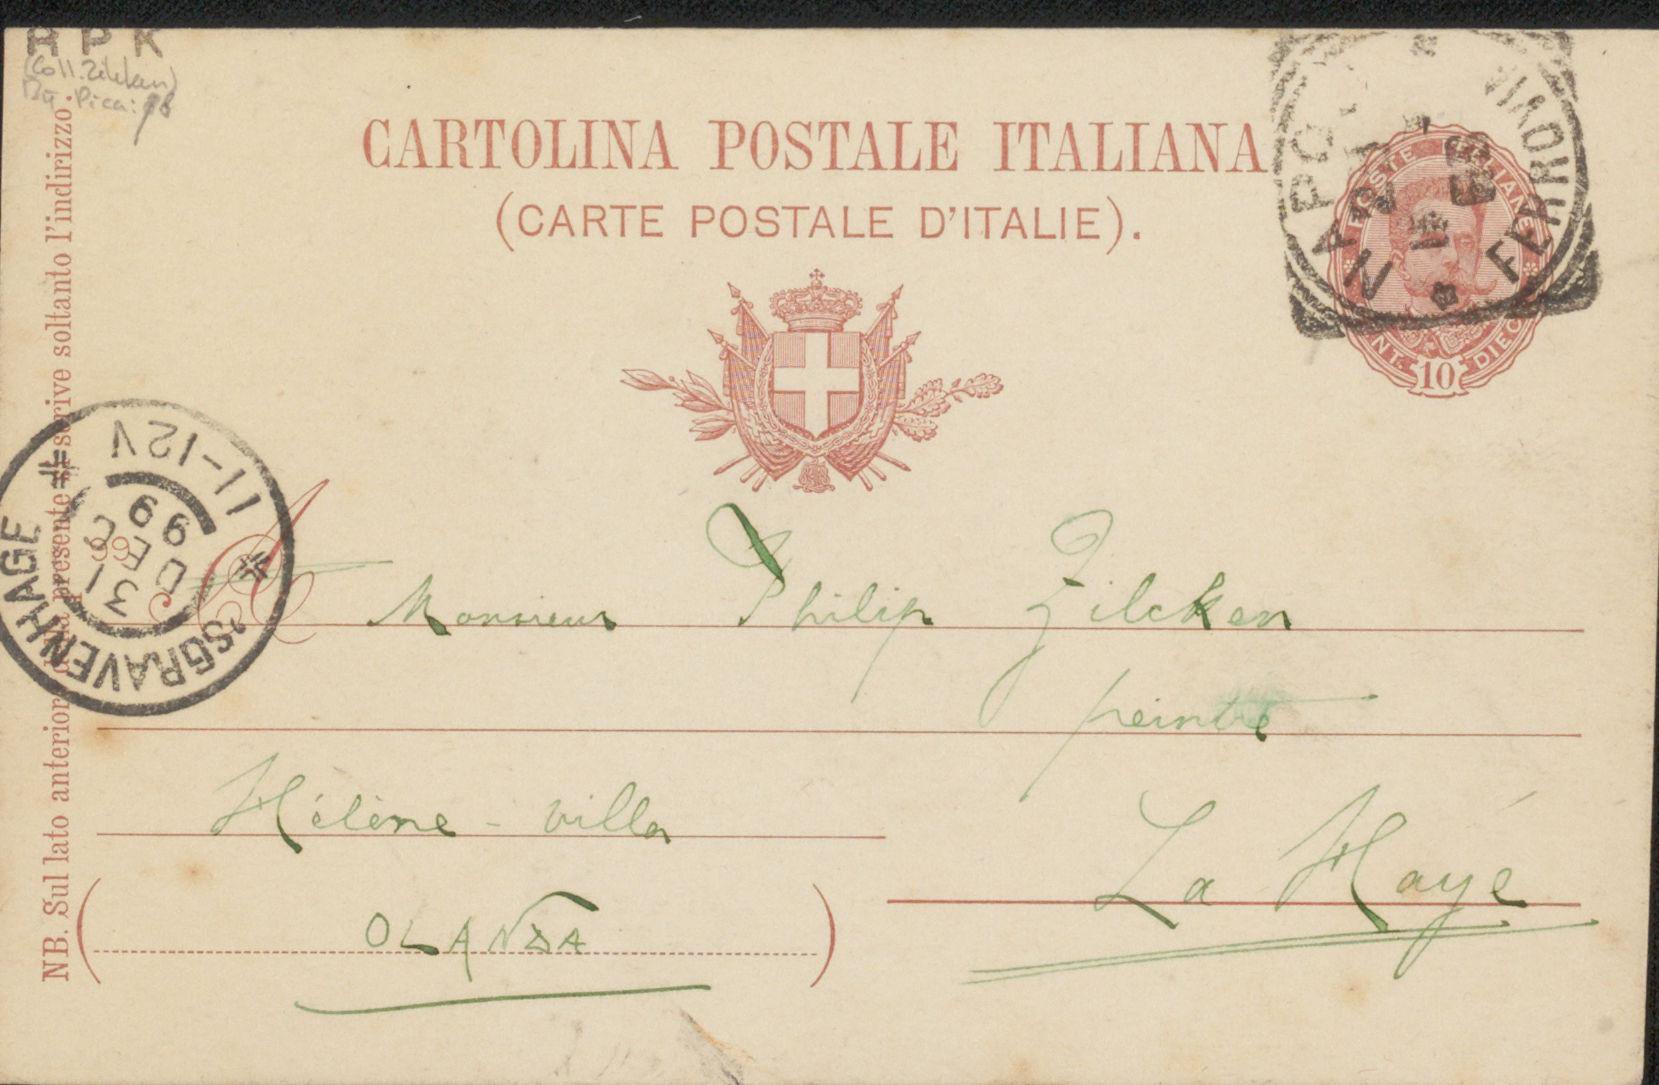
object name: postcard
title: Briefkaart aan Philip Zilcken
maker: vittorio pica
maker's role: criticus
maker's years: 1864-1930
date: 1899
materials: cardboard, ink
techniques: pen, writing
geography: naples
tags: the hague, painter, draughtsman, philip zilcken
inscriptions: collector's mark: ‘RPK’